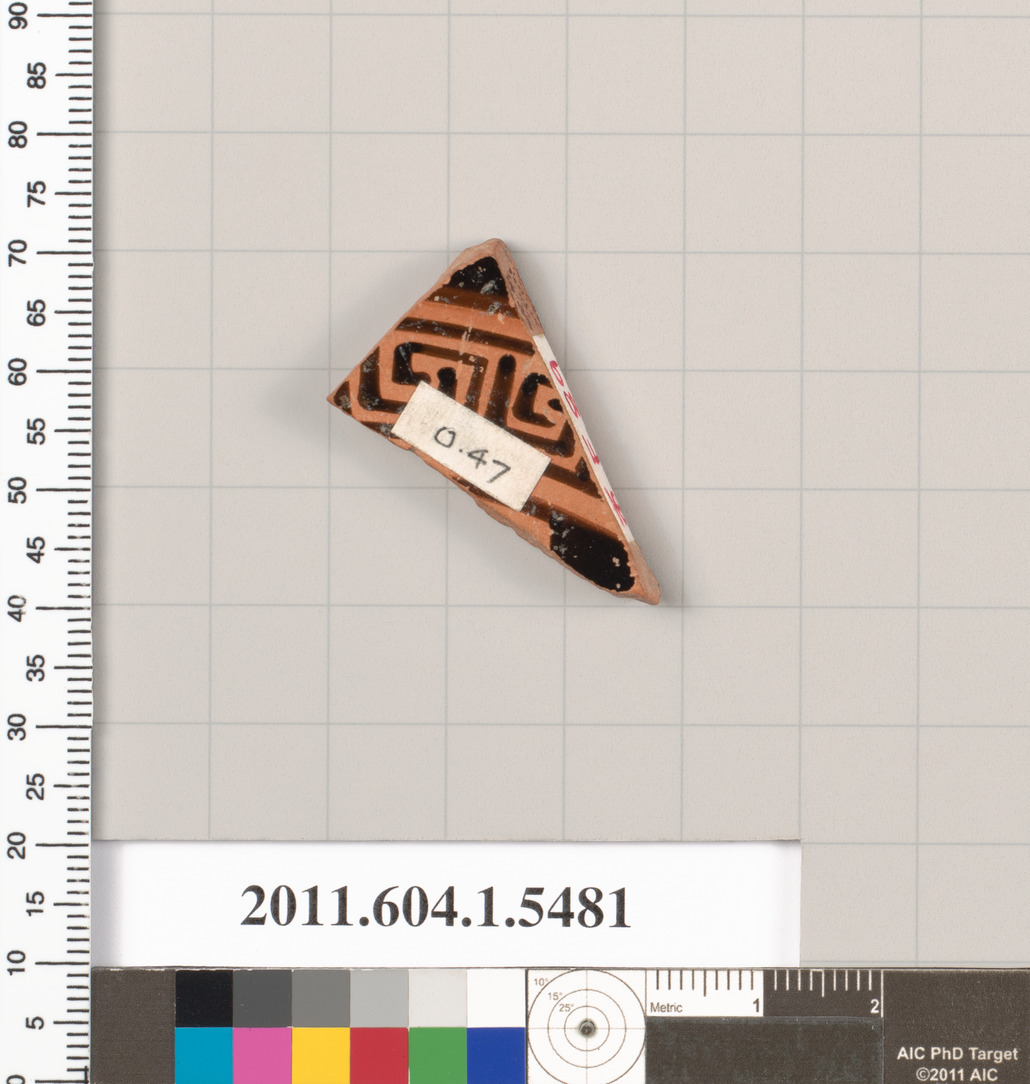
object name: kylix fragment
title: Terracotta fragment of a kylix (drinking cup)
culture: greek, attic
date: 500-480 BCE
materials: terracotta